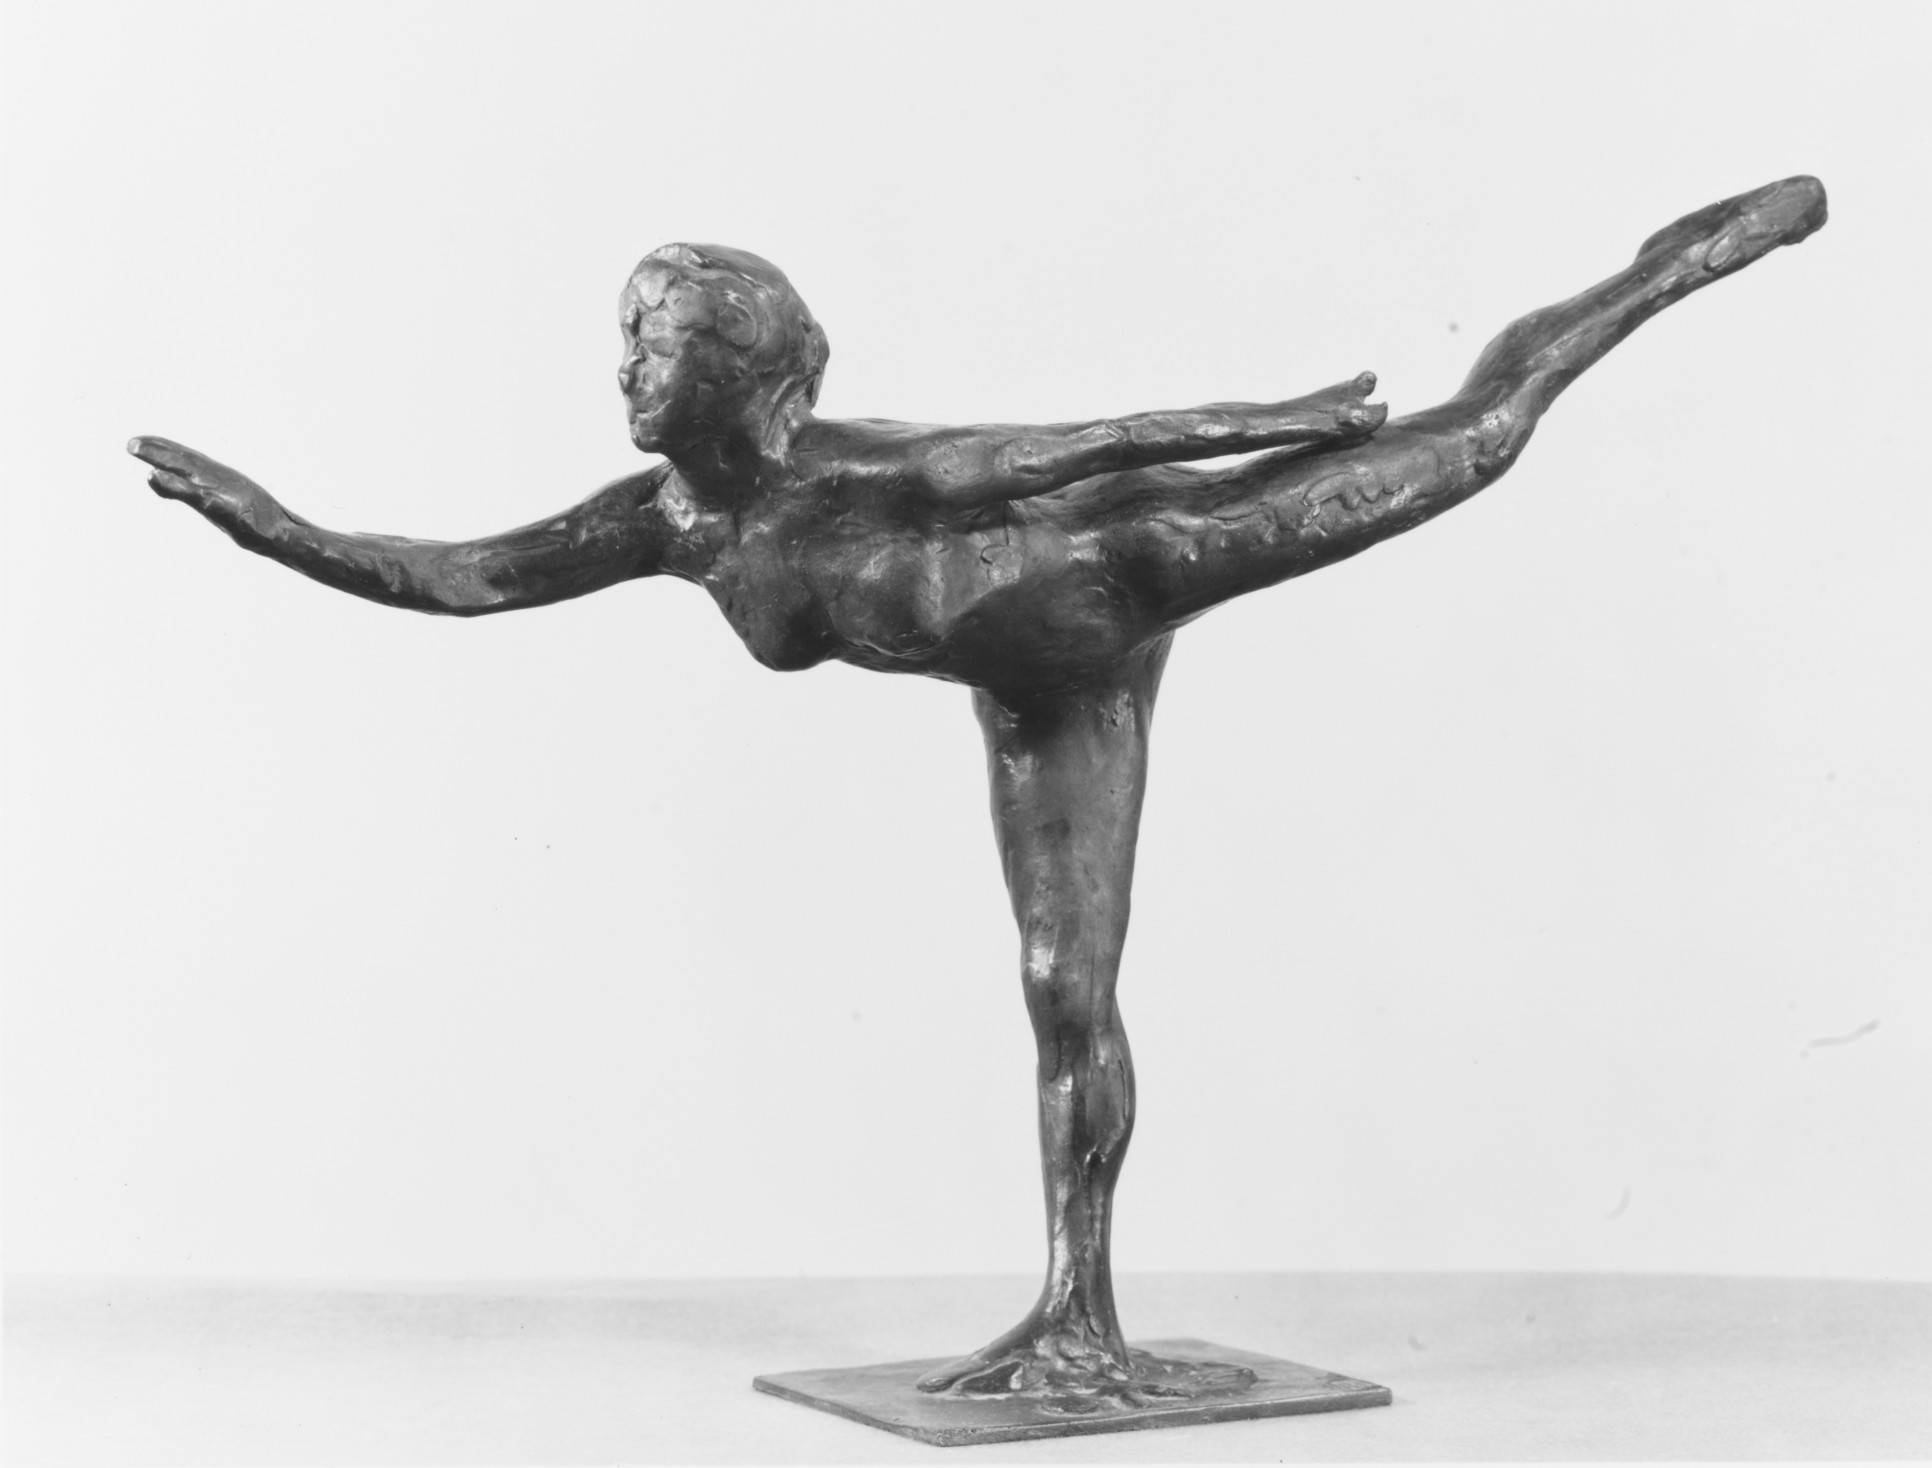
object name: statuette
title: Second Arabesque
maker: edgar degas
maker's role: artist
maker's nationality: french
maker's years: 1834-1917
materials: bronze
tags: women,dancing,dancers,ballet